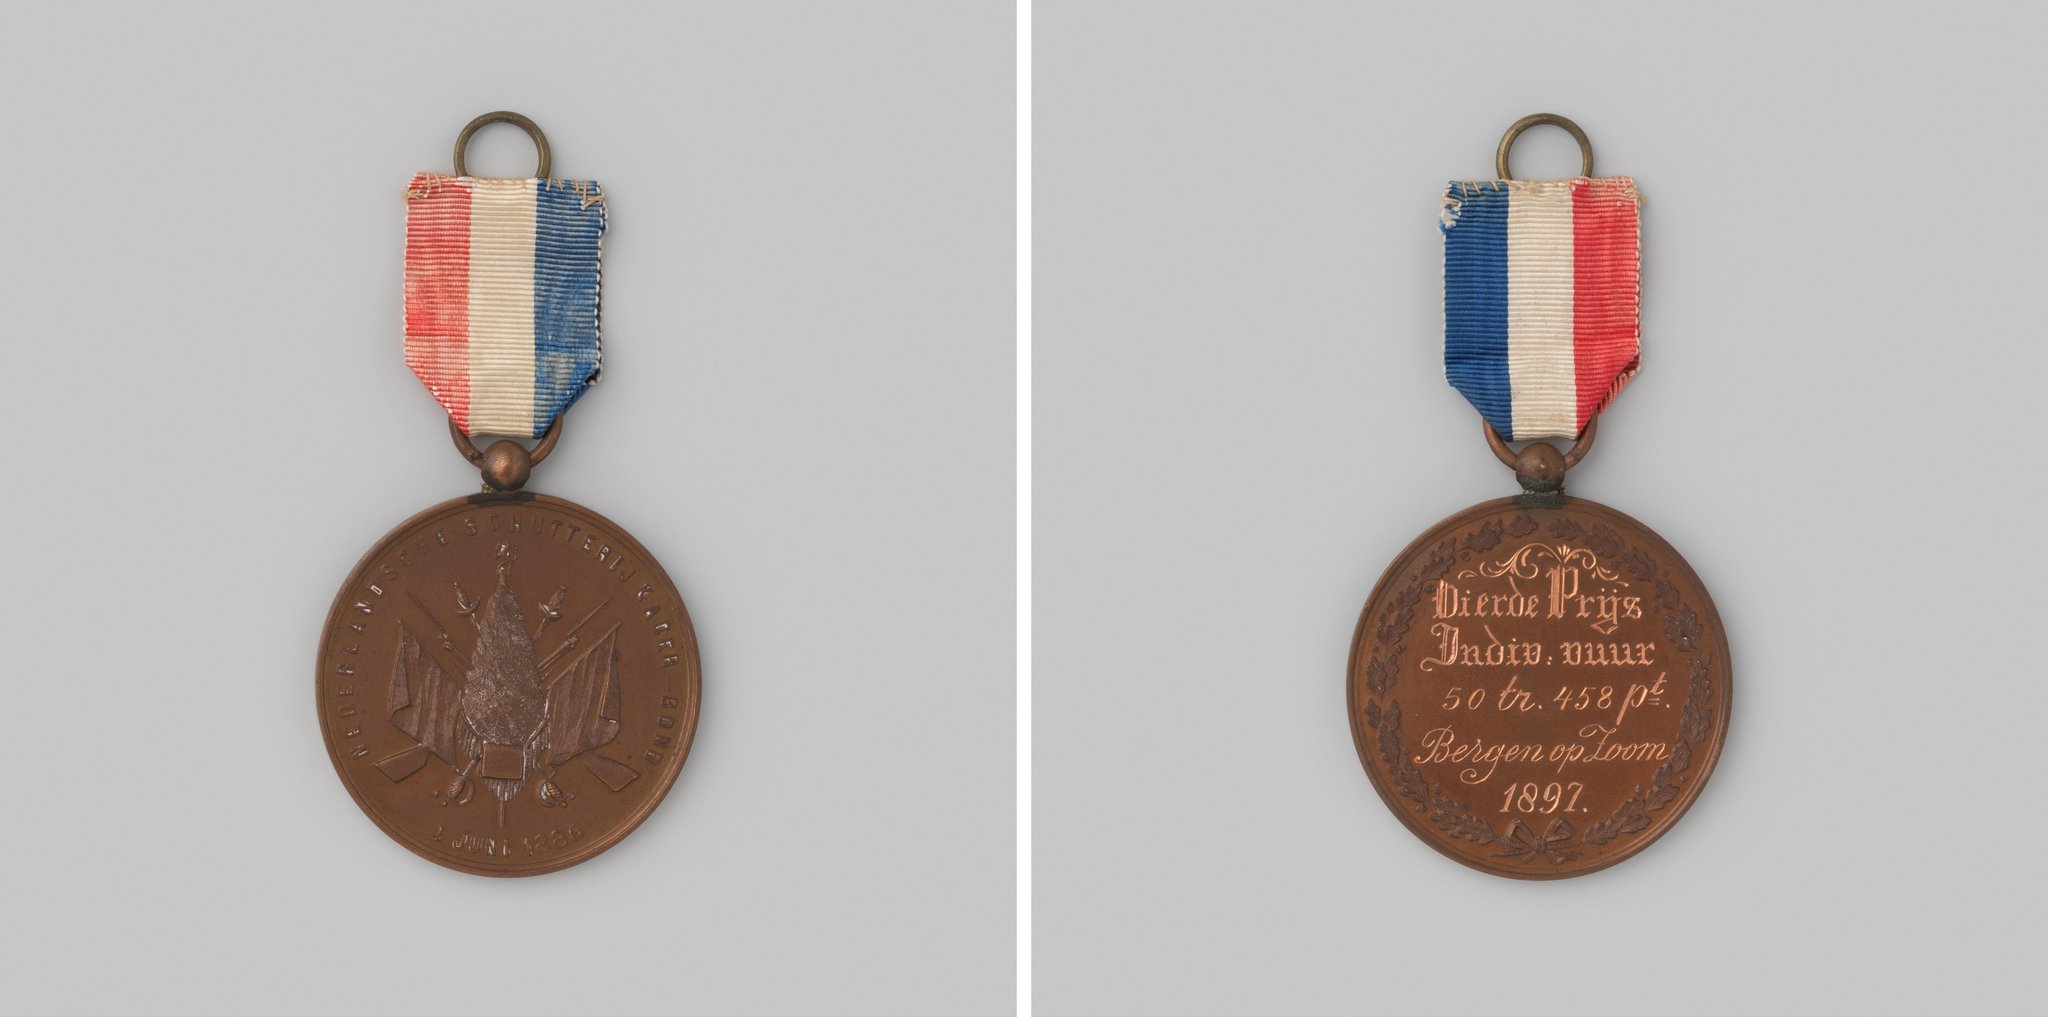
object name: draagpenning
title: Prijspenning van de Nederlandsche Schutterij Kaderbond te Bergen op Zoom, 1897, behaald door de afdeling Amsterdam, individueel vuur, vierde prijs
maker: Anonymous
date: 1897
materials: bronze, textile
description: Bronzen draagpenning met knop, ring en lint.